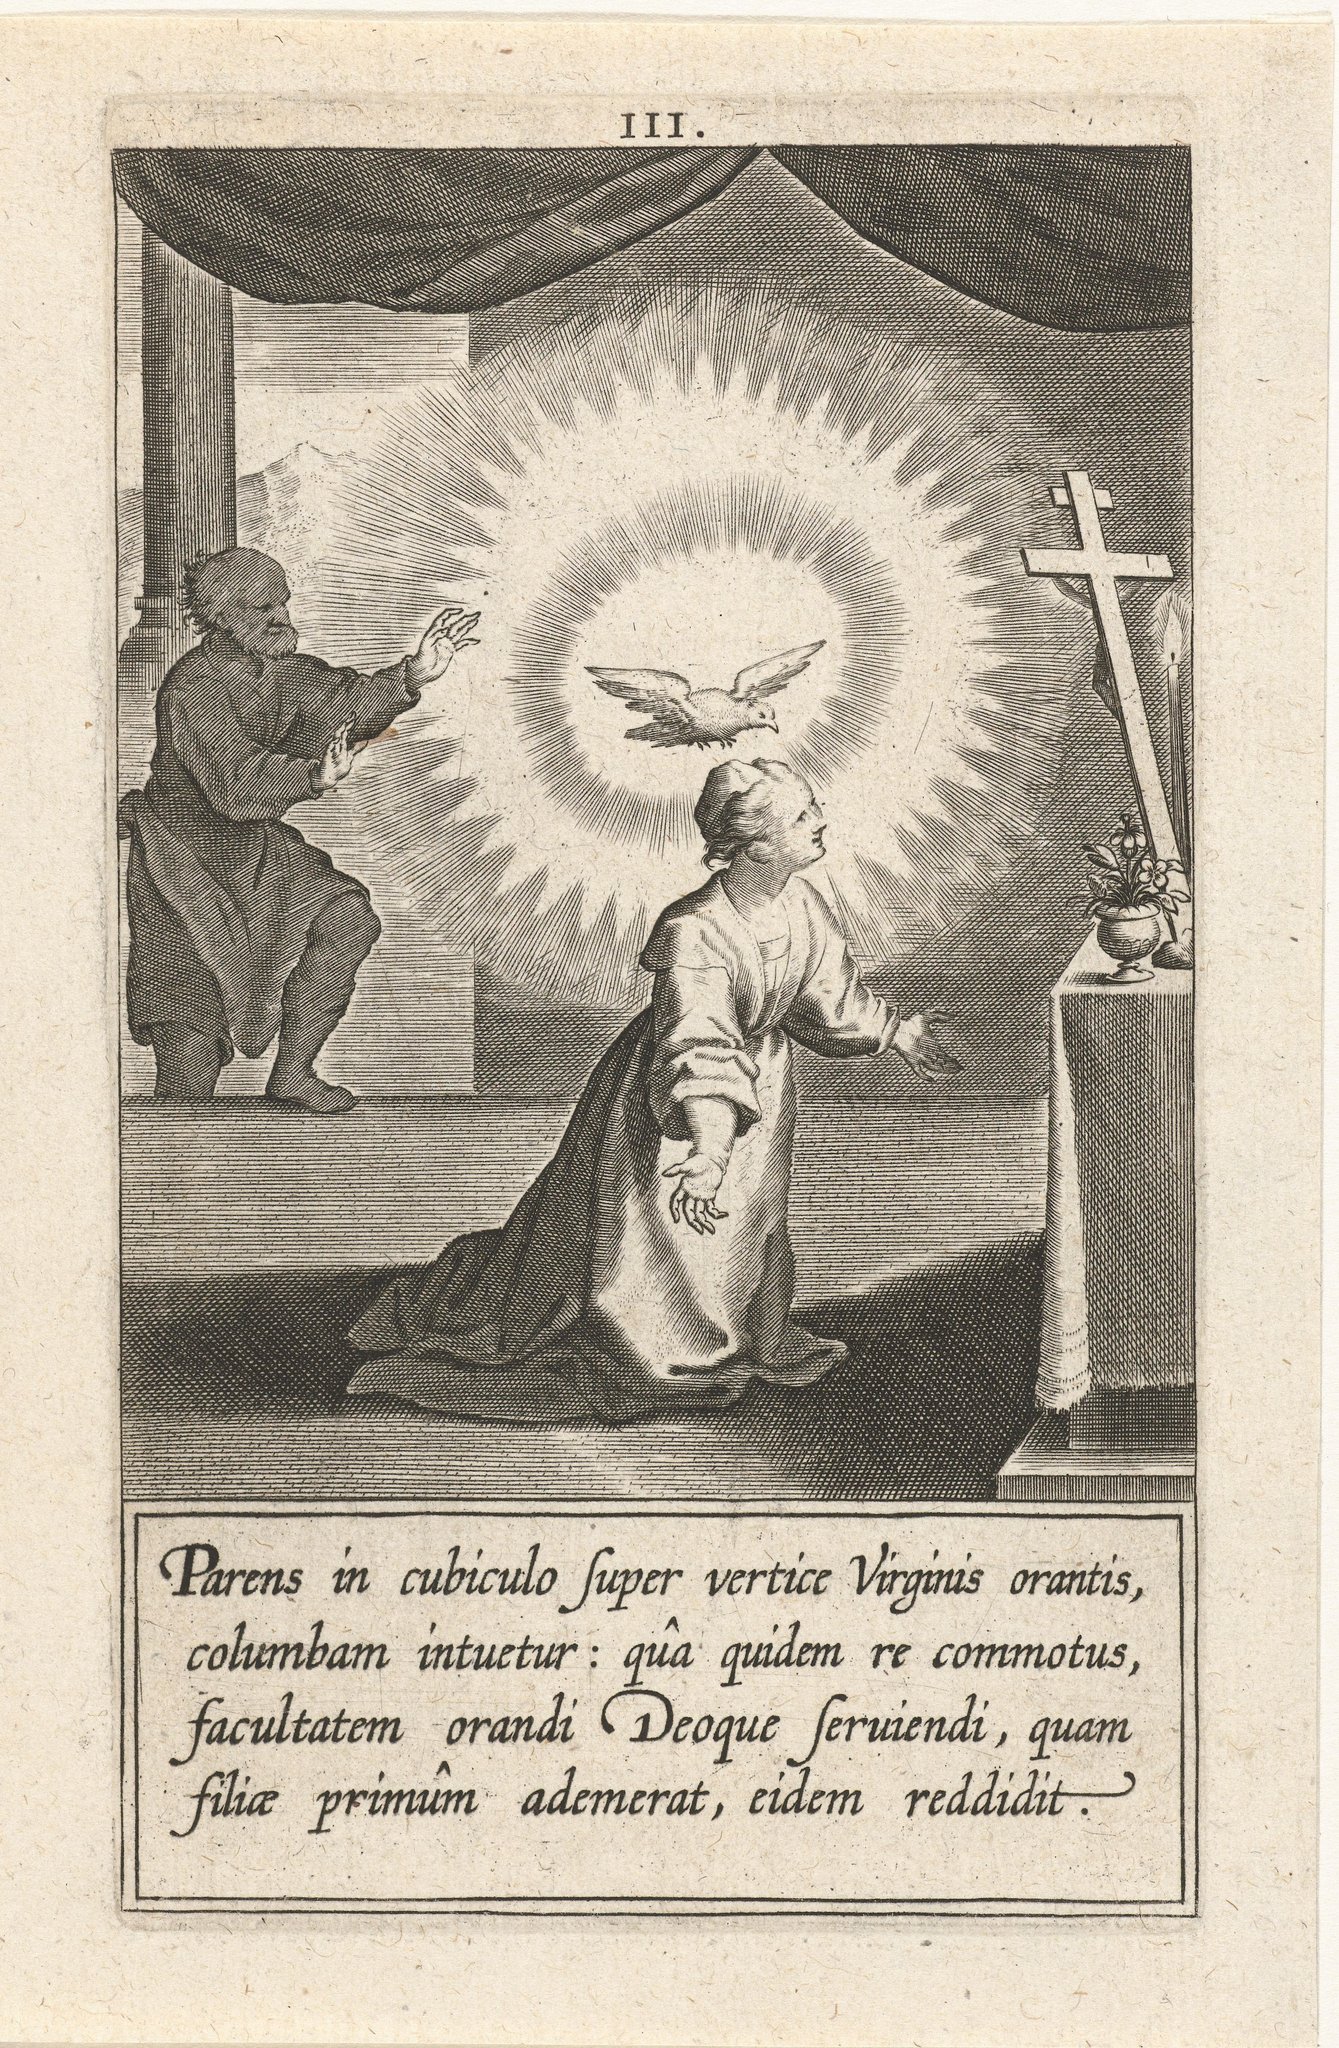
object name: print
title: Catharina in gebed met duif boven haar hoofd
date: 1603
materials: paper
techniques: engraving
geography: southern netherlands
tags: the virgin and dominican tertiary, catherine of siena; possible attributes: book, cross, crown of thorns, crucifix, demon under foot, heart (with cross), lily, plague-stricken, ring, rosary, stigmata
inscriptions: collector's mark: Lugt 2228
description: Tijdens Catharina's gebed zweeft een witte duif in stralenkrans boven haar hoofd. Haar vader die dit toevallig ziet is vanaf nu overtuigd van haar bijzondere status en oefent verder geen druk meer op haar uit om ze tot een huwelijk te bewegen. Deel van een serie over Catharina van Siena bestaande uit een titelprent, een portret en 32 genummerde scènes uit haar leven.